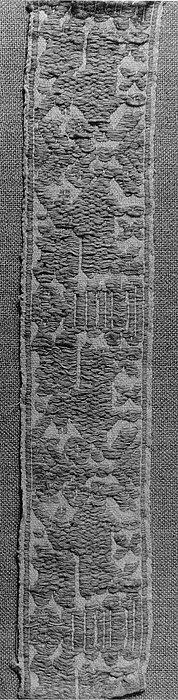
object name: band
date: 1701-1800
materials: cotton, linen